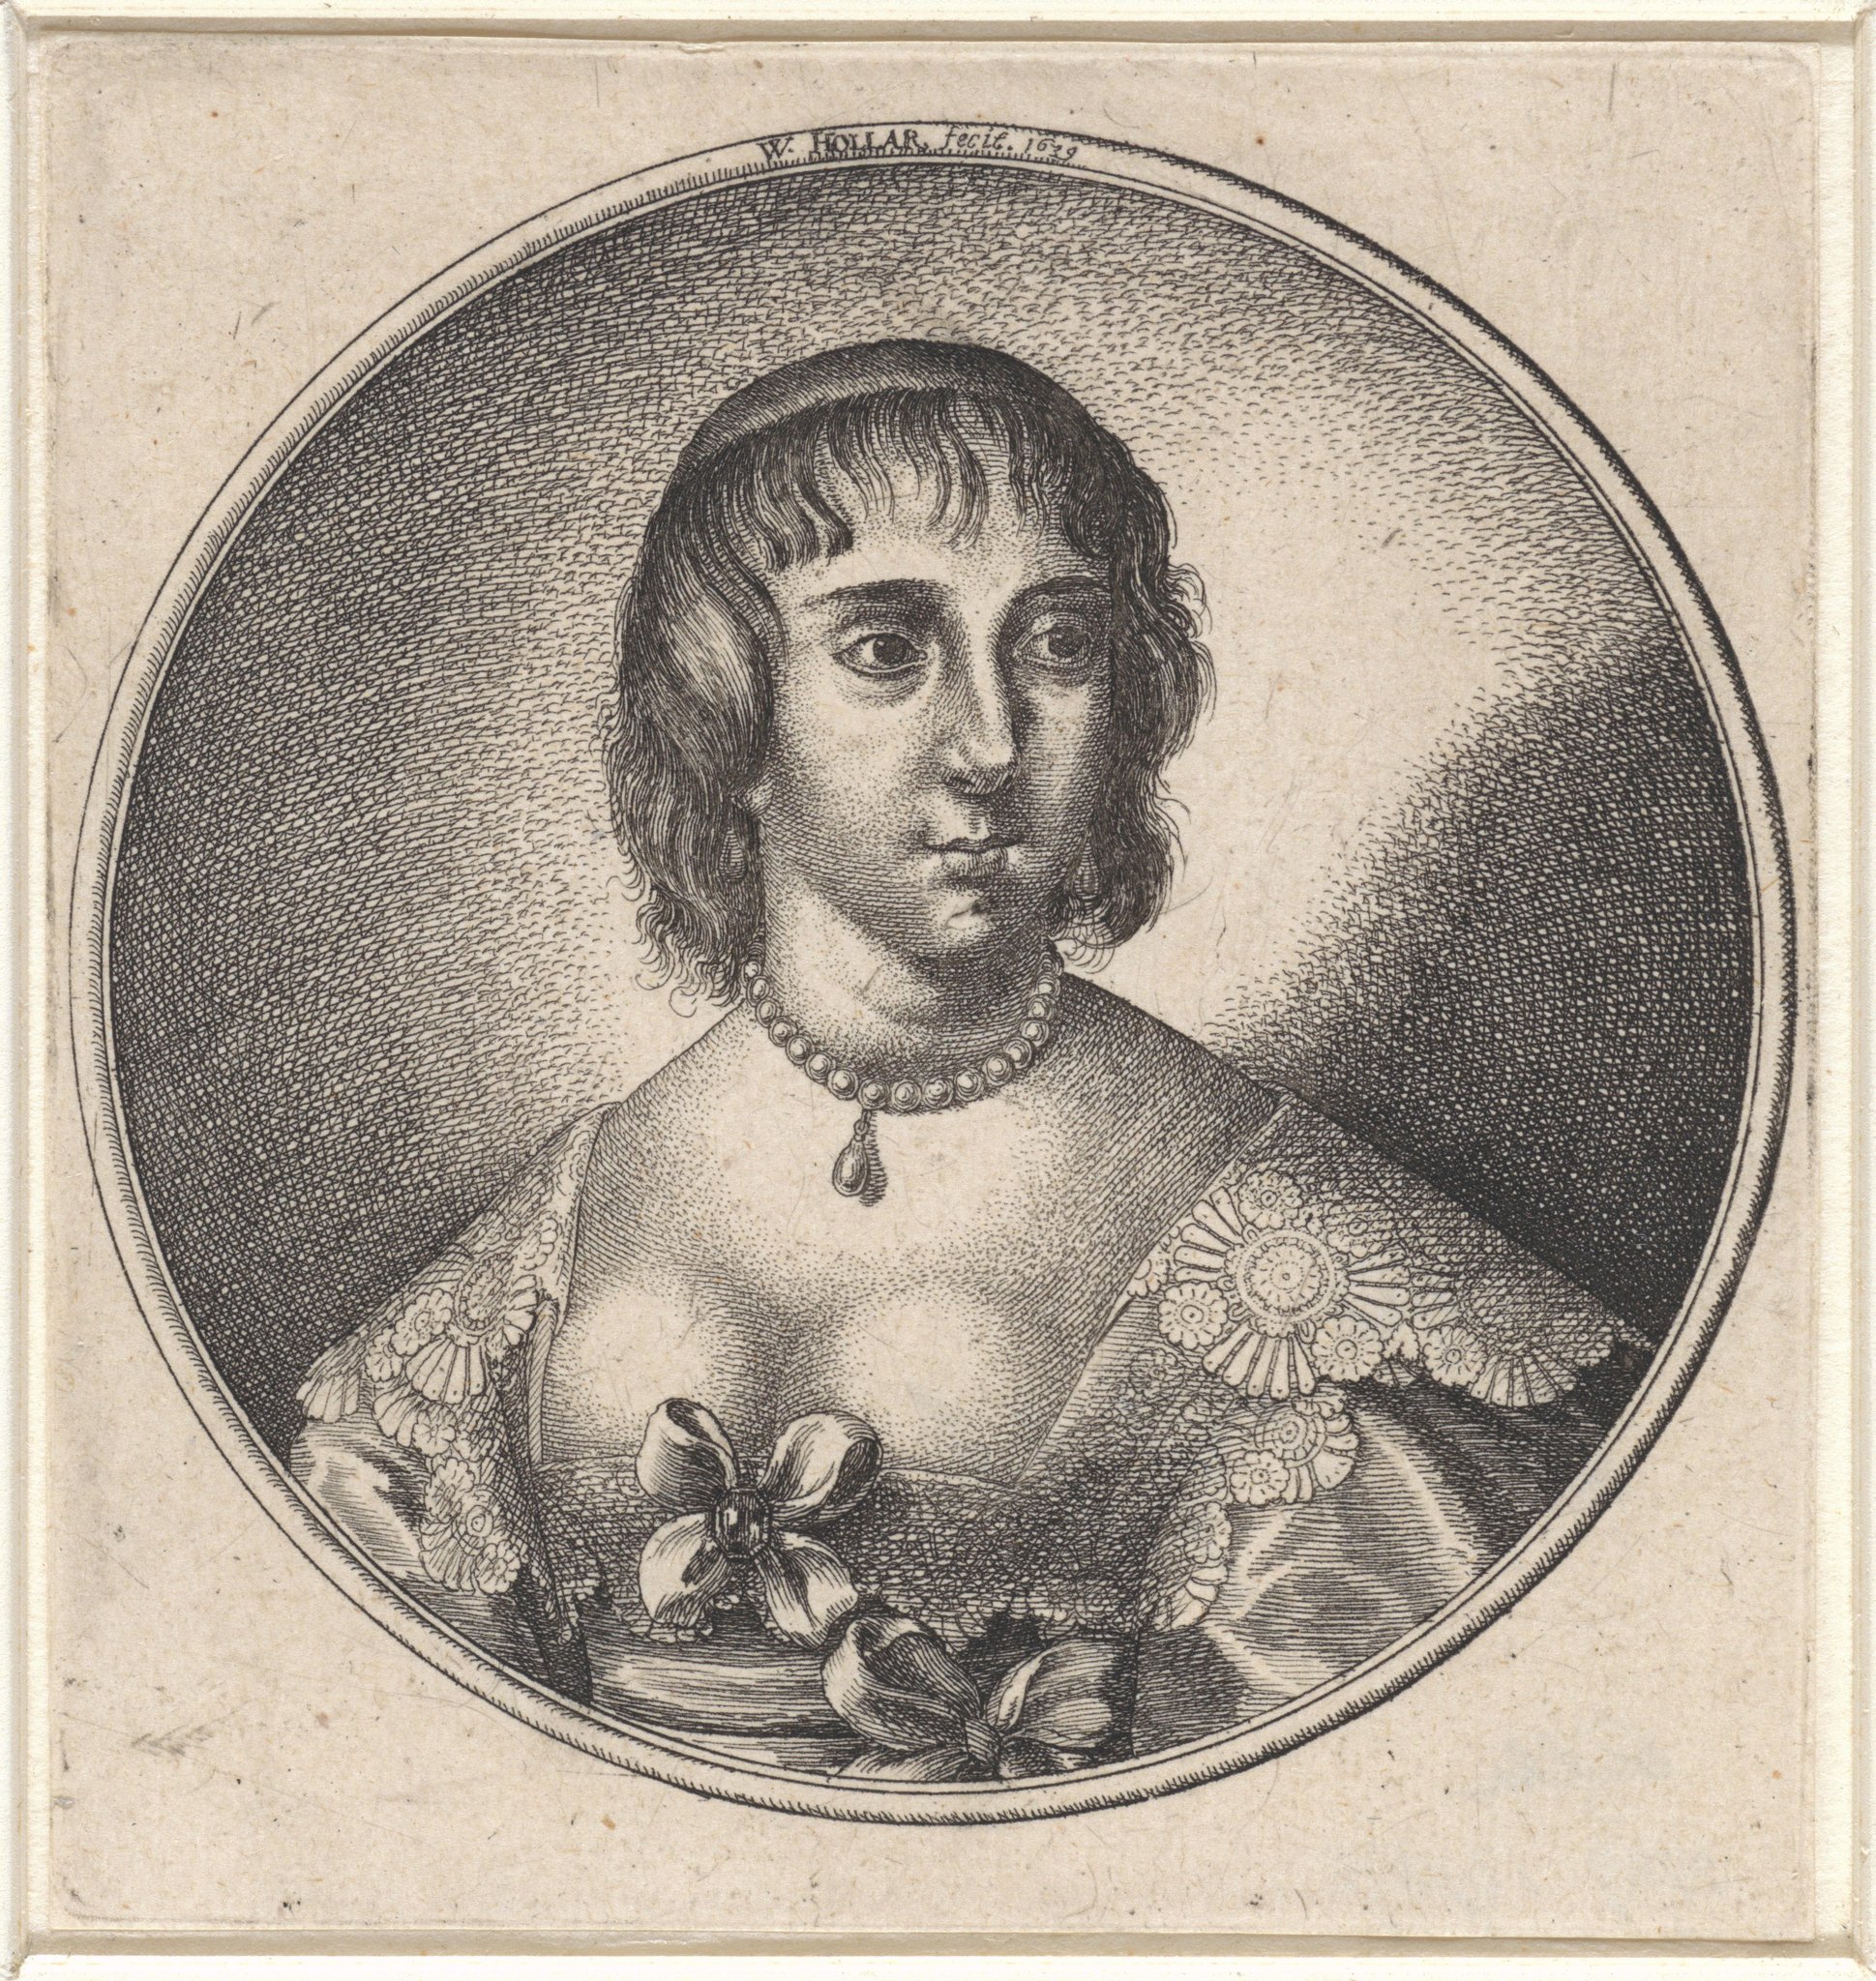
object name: print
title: Vrouw met laag decolleté, versierd met strik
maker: wenceslaus hollar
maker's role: draughtsman, print maker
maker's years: 1607-1677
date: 1639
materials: paper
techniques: etching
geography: london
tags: anonymous historical person portrayed alone - bb - woman, bow (ornamental part of clothing), pearl; pearl necklace (+ women's clothes)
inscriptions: collector's mark: Lugt 654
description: De prent maakte enkele jaren later mogelijk deel uit van een 13-delige serie met vrouwenbusten in medaillons (1642-1643).